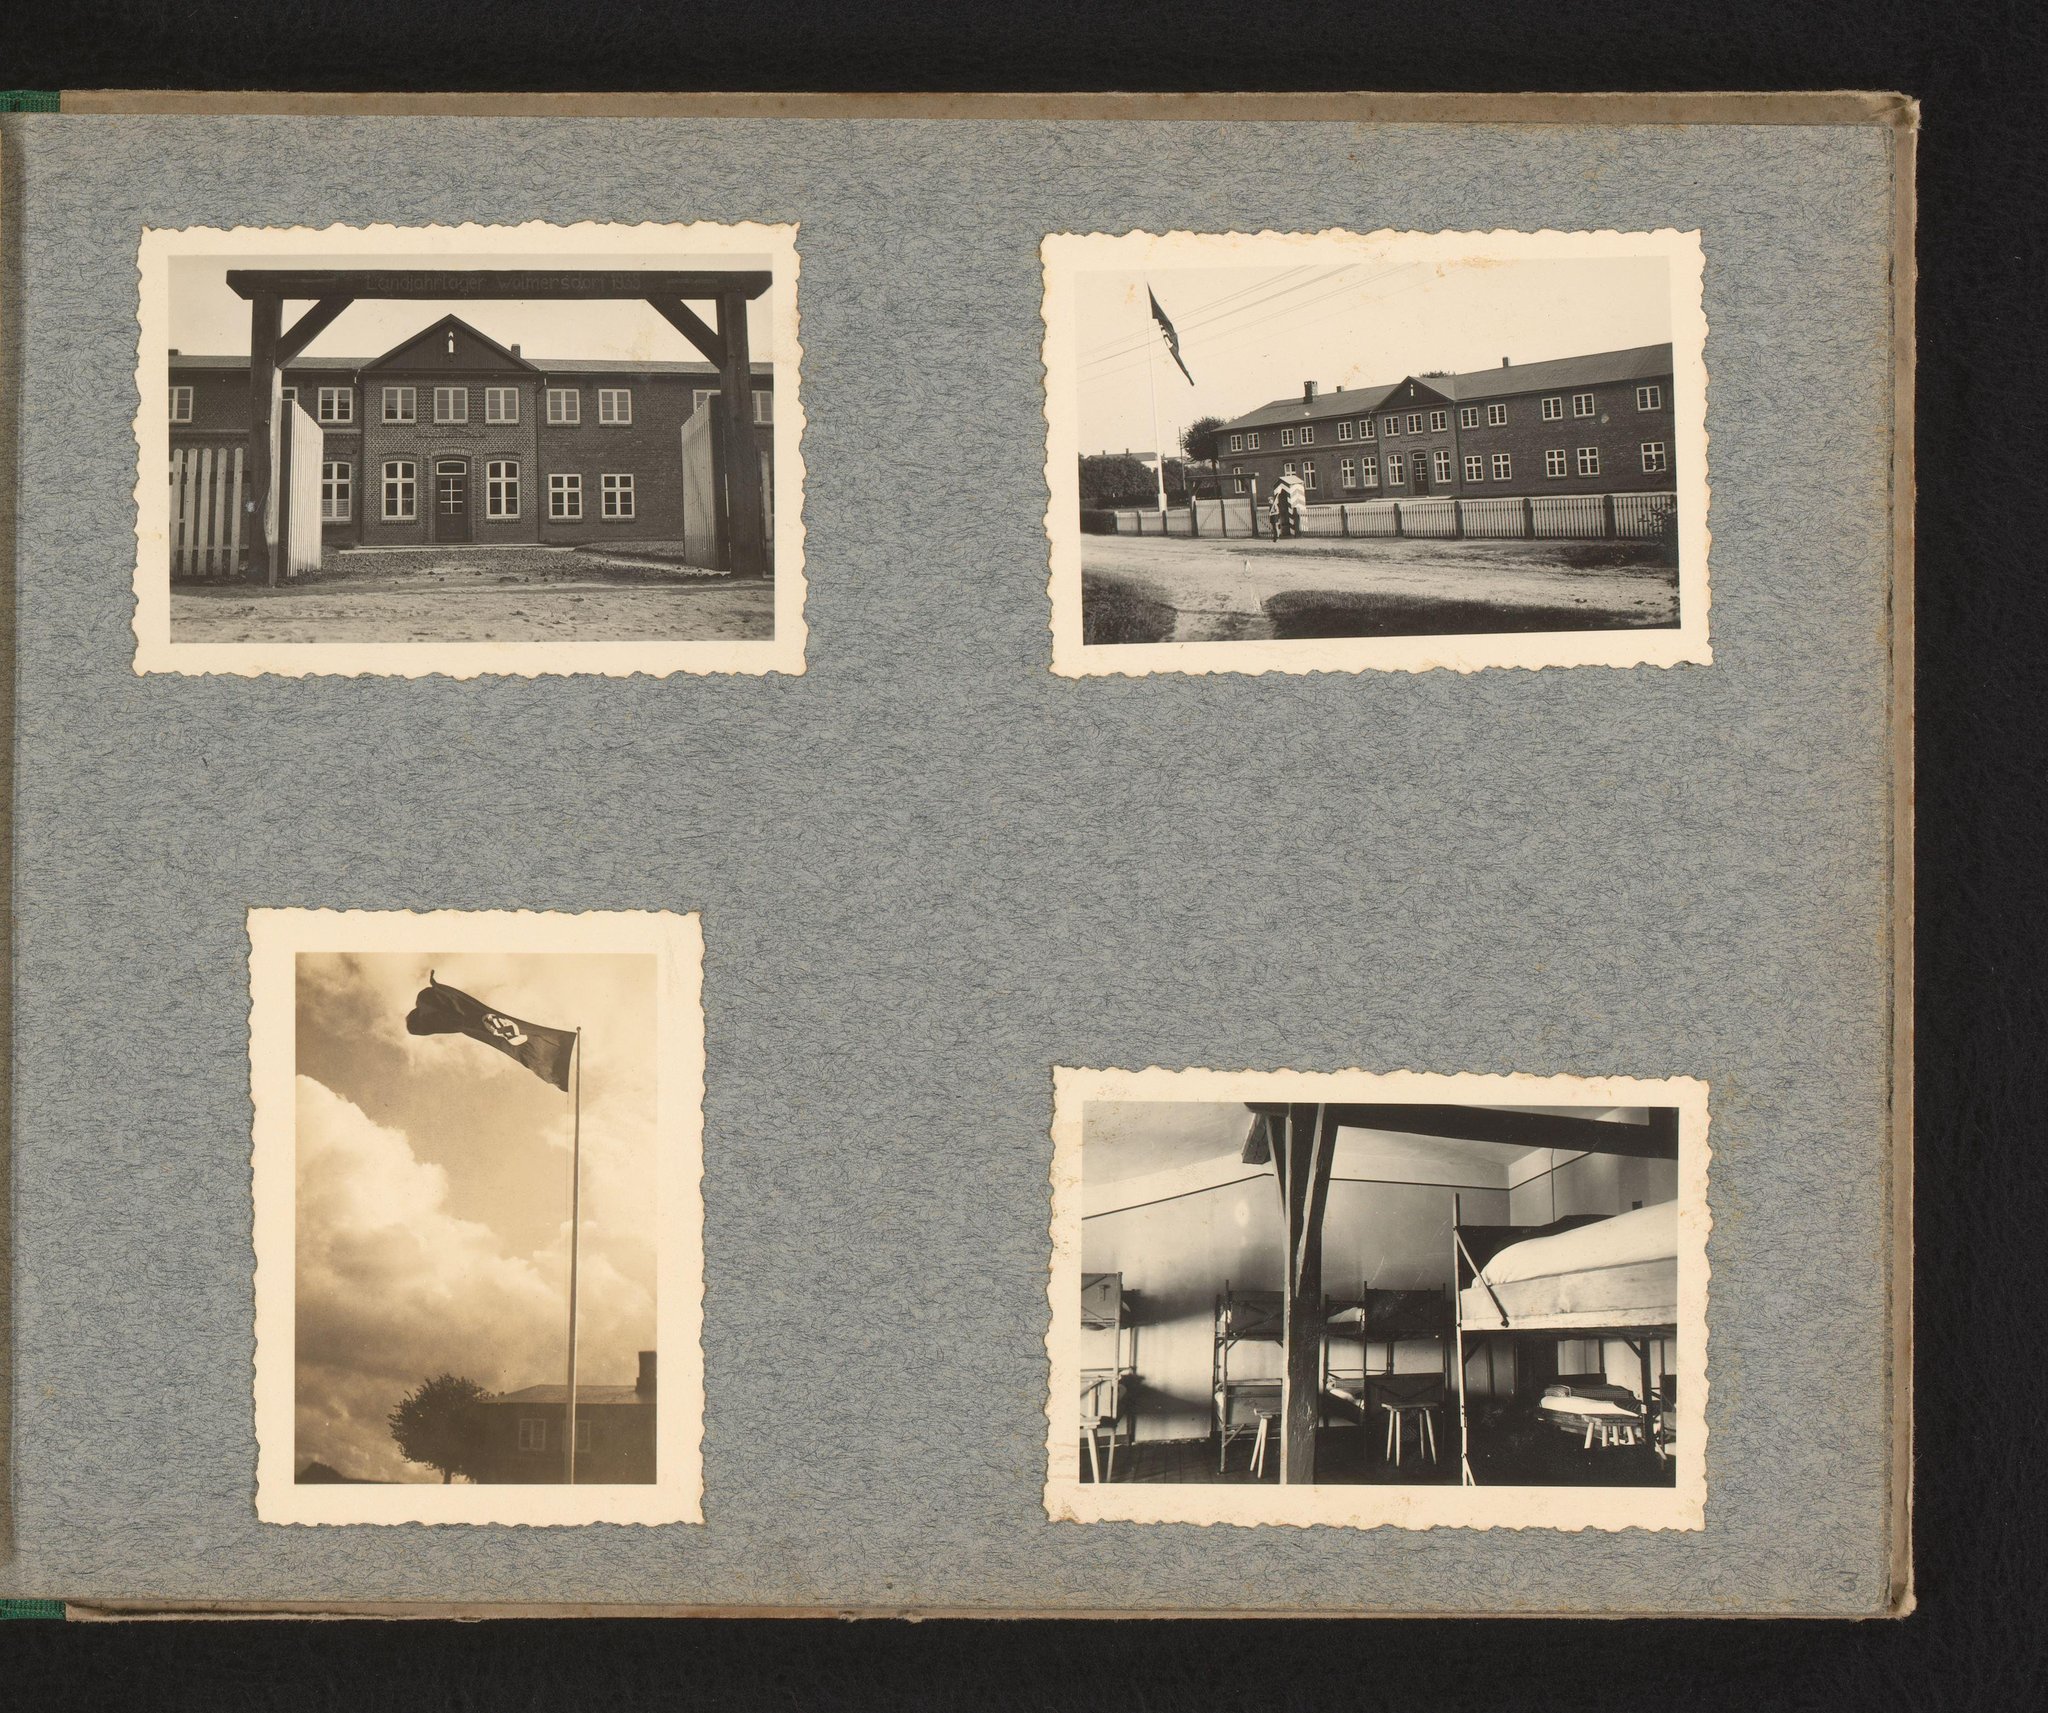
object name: album leaf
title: Landjahrlager 1935 in Wolmersdorf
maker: Anonymous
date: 1935-1938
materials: cardboard, photographic support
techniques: gelatin silver print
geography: germany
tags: assembling of military forces; mobilization, troop concentration, etc., germany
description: Albumblad met vier foto's van het gebouw van de Hitlerjugend, op de poort staat 'Landjahrlager Wolmersdorf 1935'. Onderdeel van het Hitlerjugend fotoalbum.